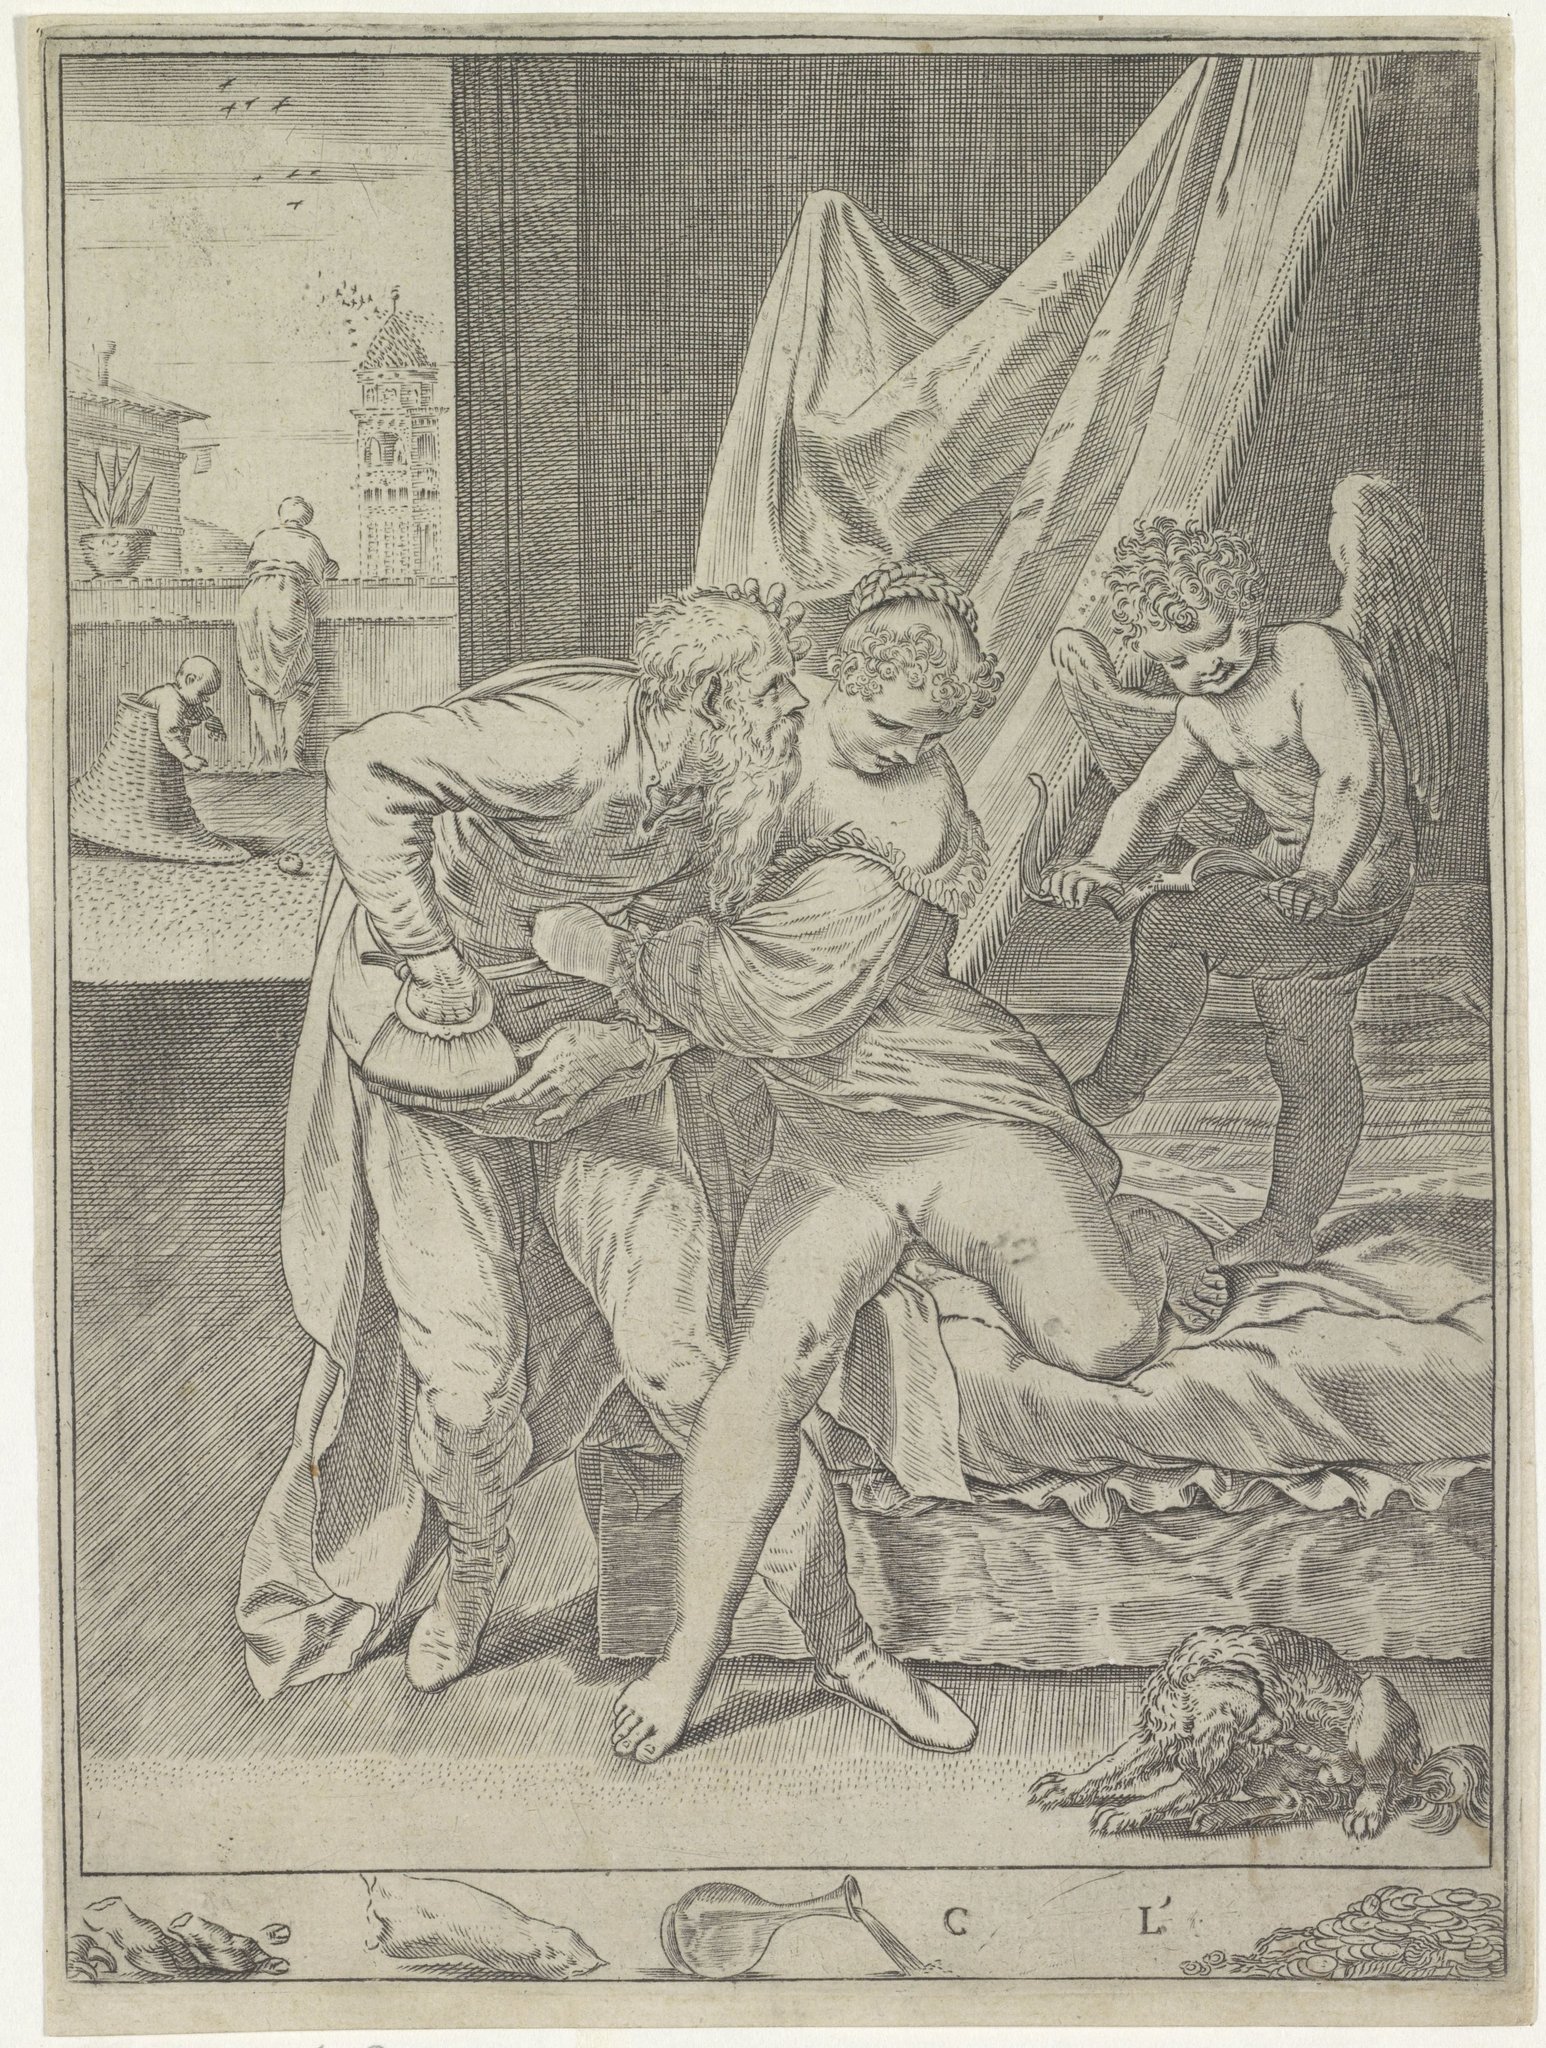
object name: print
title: Oude man en een courtisane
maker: agostino carracci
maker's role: draughtsman, painter, print maker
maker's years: 1557-1602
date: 1590-1595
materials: paper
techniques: engraving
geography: italy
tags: old man, courtesan, hetaera, rebus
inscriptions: collector's mark: Lugt 240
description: Een jonge vrouw zit half op een hemelbed en weert een oude man af. Deze tast in zijn forse geldbuidel. Amor staat op het bed en breekt zijn boog doormidden. Voor het bed ligt een hond. In de ondermarge een rebus die leest 'ogni cosa vince l'oro' (alles wint goud?).